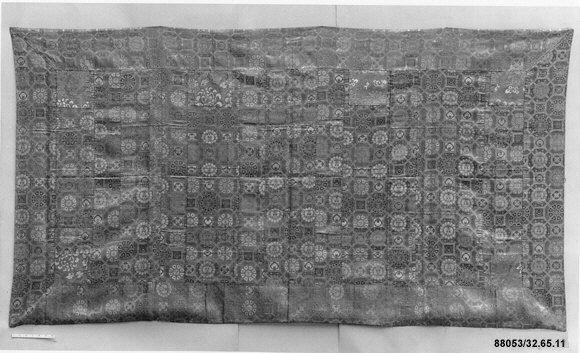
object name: robe, priest's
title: Priest's Robe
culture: japanese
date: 1601-1700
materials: metal thread, silk